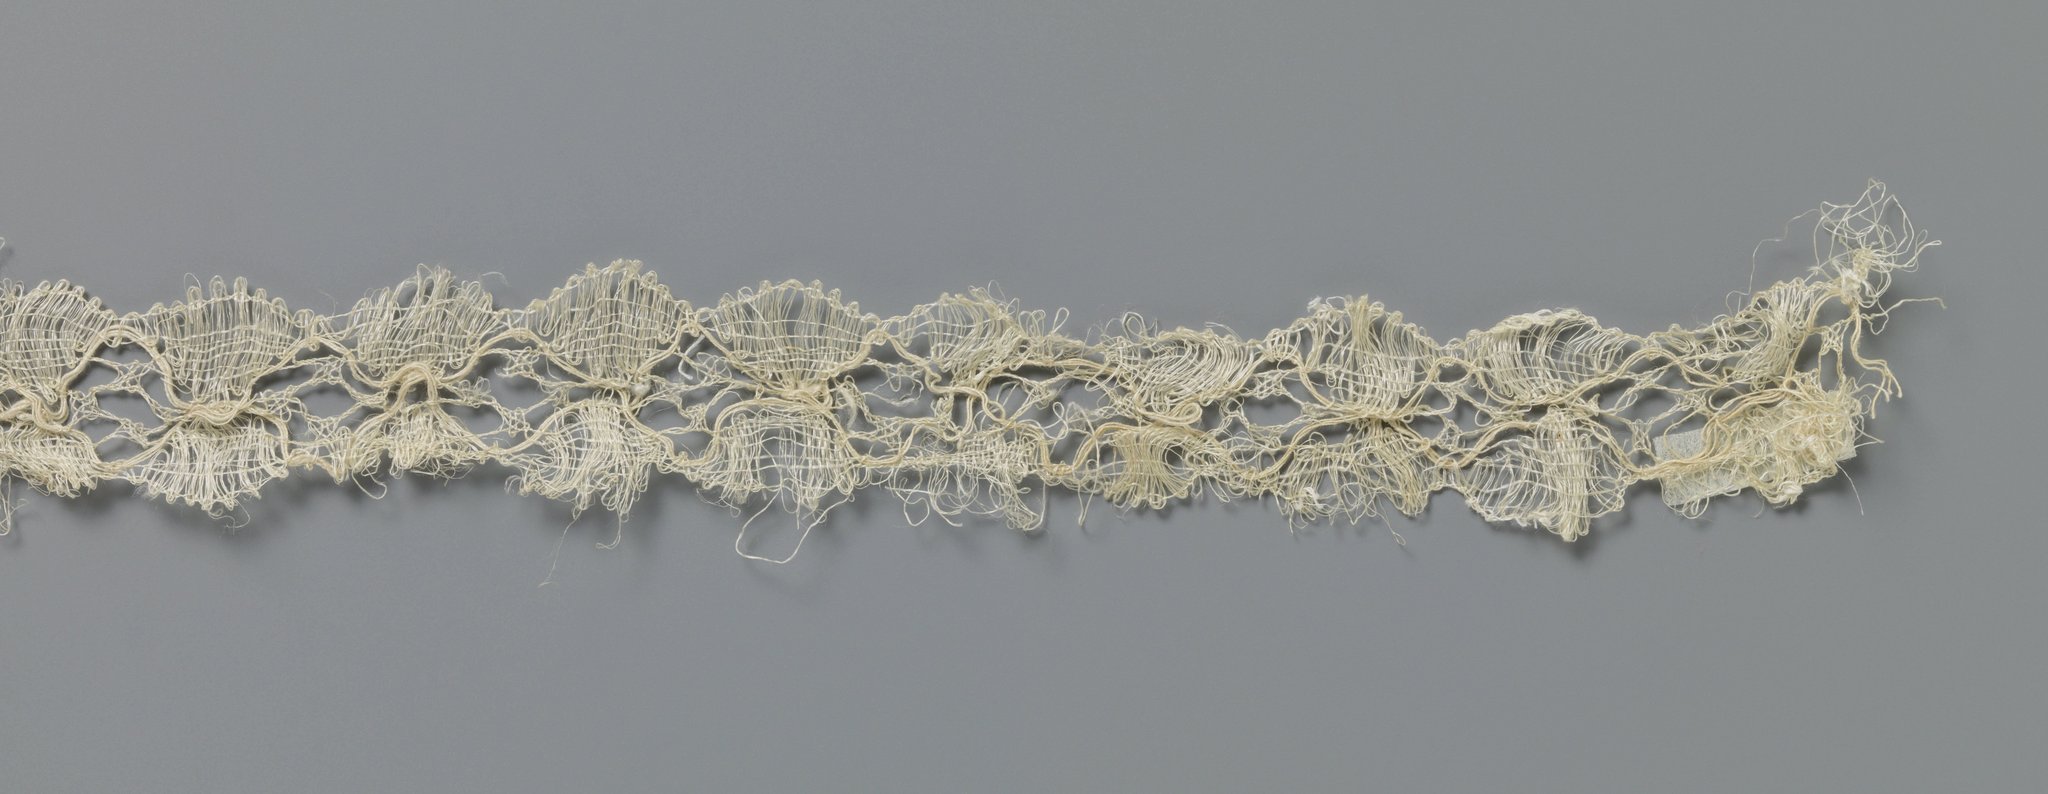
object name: strip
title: Strook kloskant met ruitvormig veld tussen gespiegelde waaiers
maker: Anonymous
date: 1840-1860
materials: silk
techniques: lace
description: Strook naturelkleurige kloskant, blonde. Het zich herhalende patroon bestaat uit een over de lengte-as gespiegelde waaier, die aan de boven- en onderzijde van de strook schulpen vormen. Tussen de gespiegelde waaiers in wordt een opengewerkt ruitvormig veld gevormd, waarin een siergrond is toegepast. De ruiten zijn voorzien van doorlopende contourdraden, die elkaar kruisen op de lengte-as.